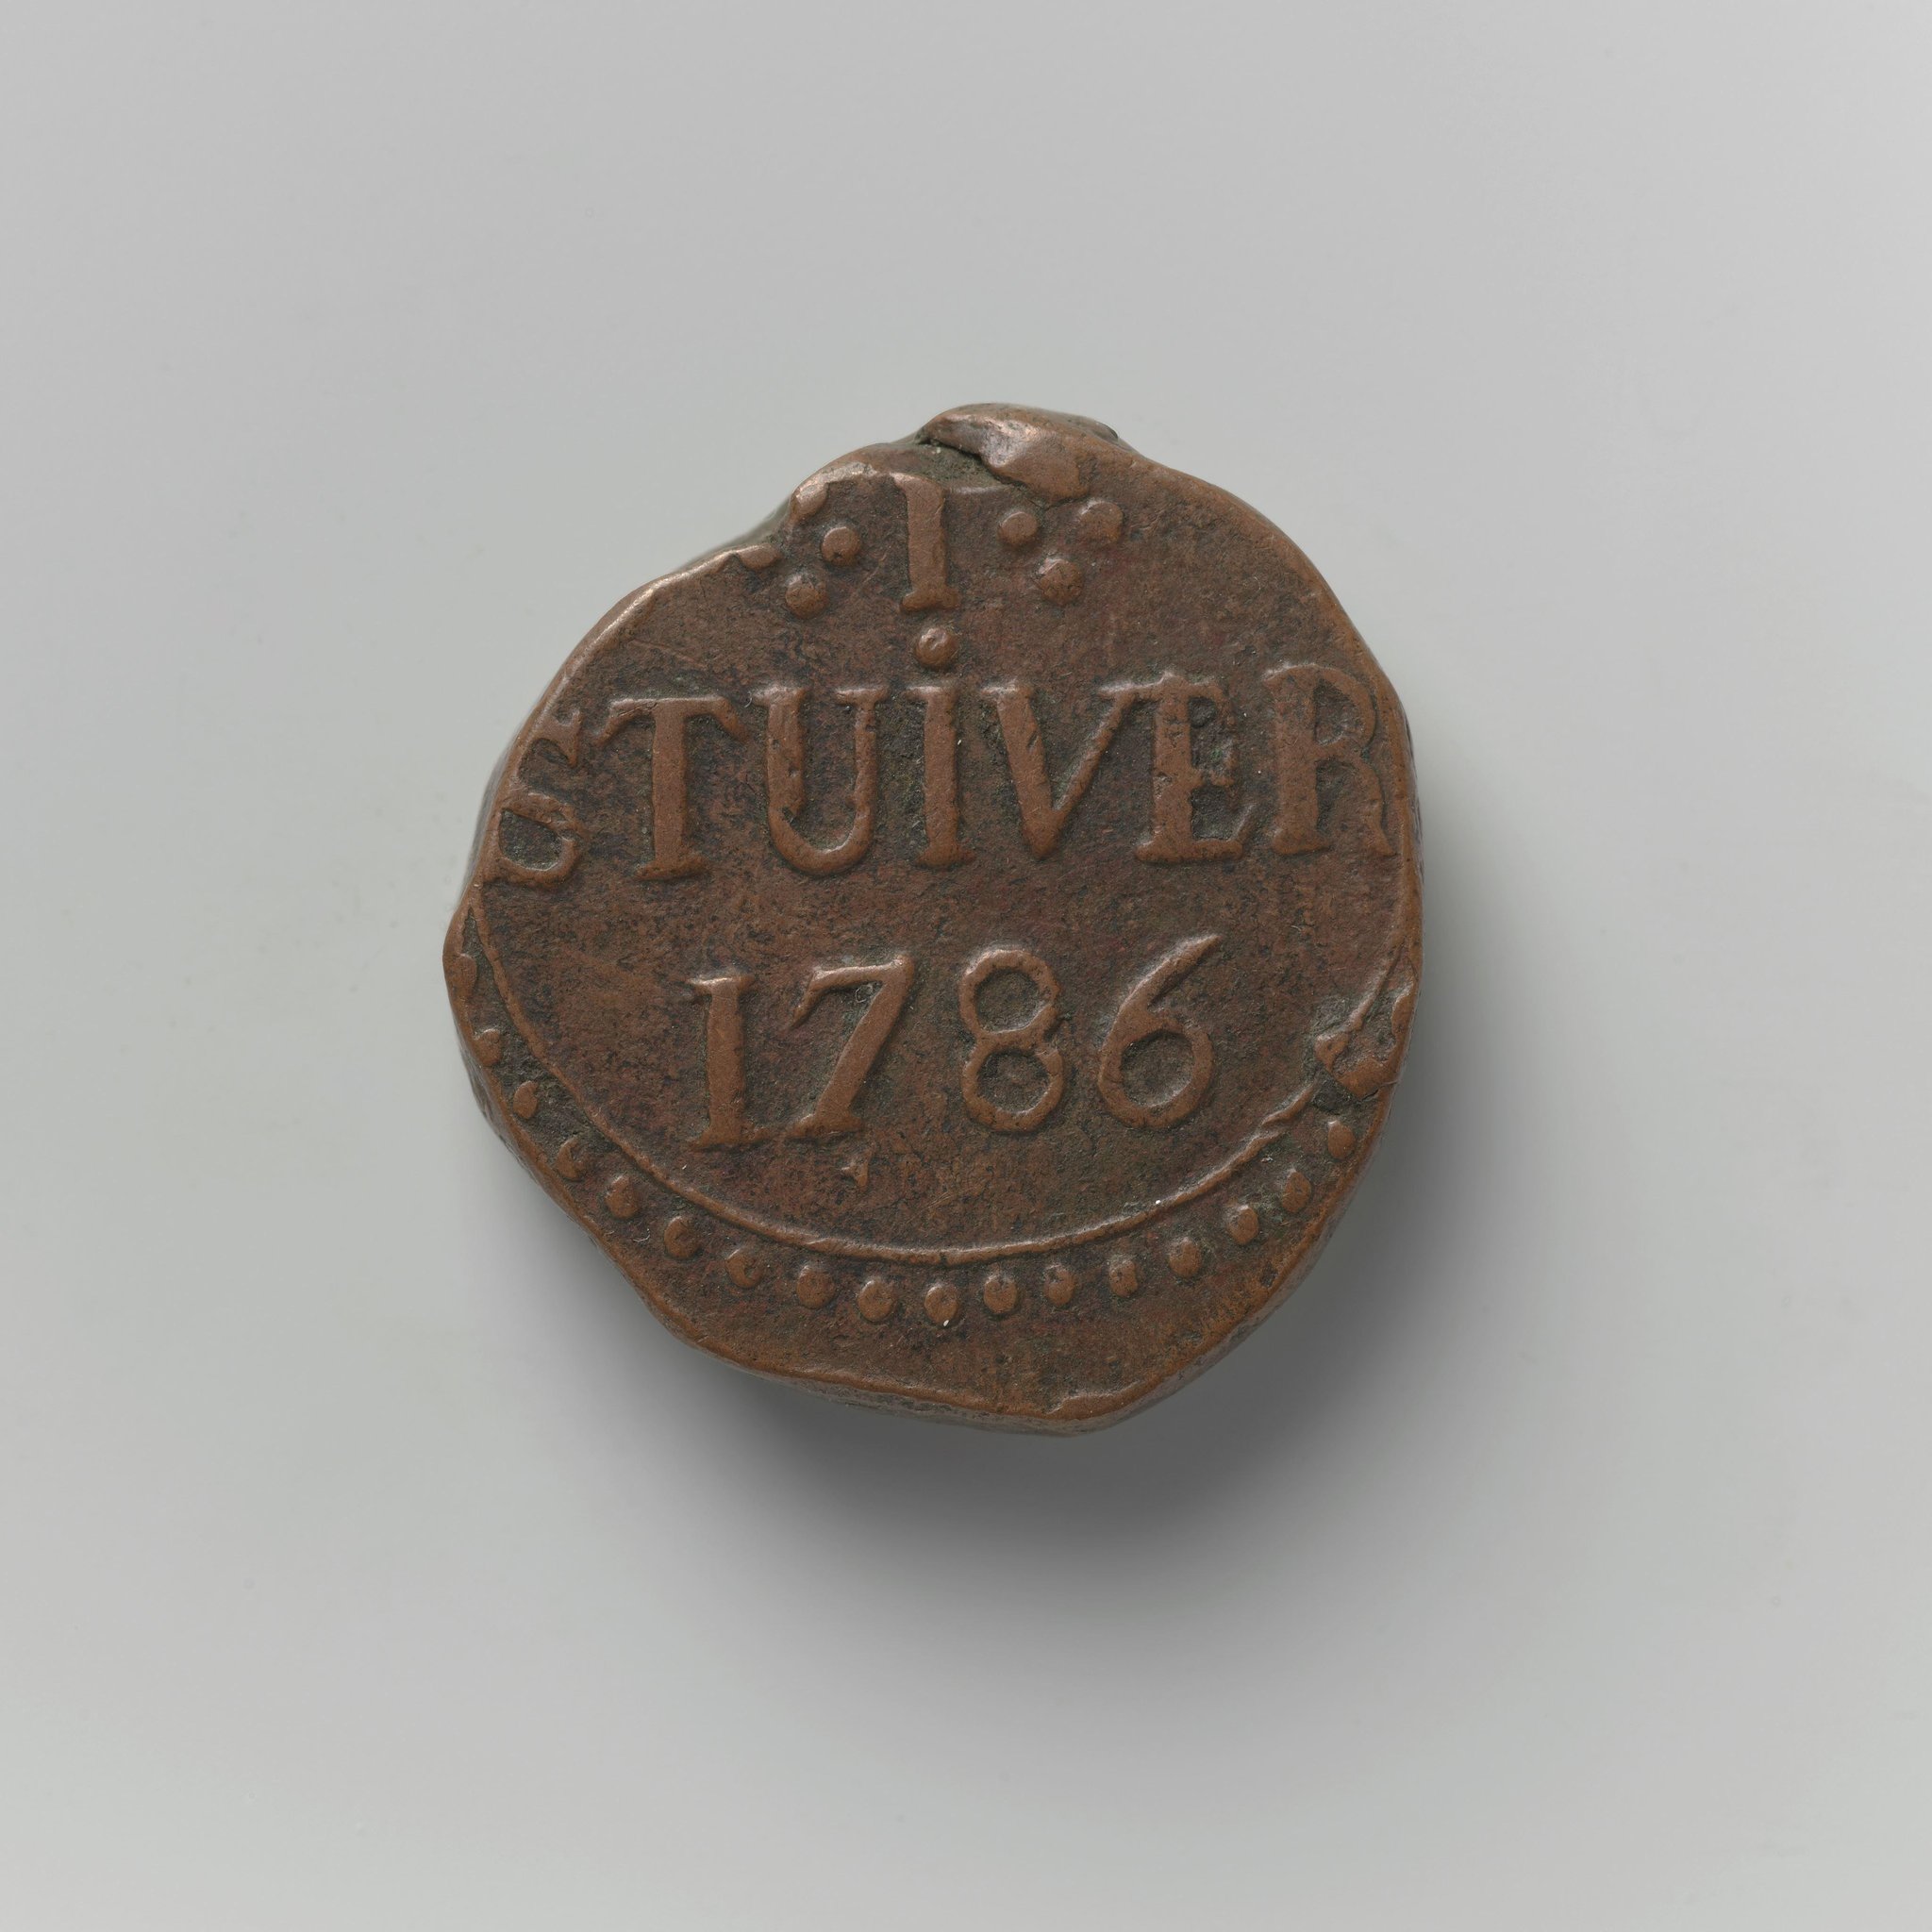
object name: coin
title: Stuiver van Ceylon, 1786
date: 1786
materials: copper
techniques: striking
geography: colombo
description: Koperen munt. Voorzijde: monogram van de VOC, waarboven letter C. Keerzijde:eenregelig opschrift: waarde-aanduiding stuiver, waarboven I en waaronder jaartal. Gladde rand.